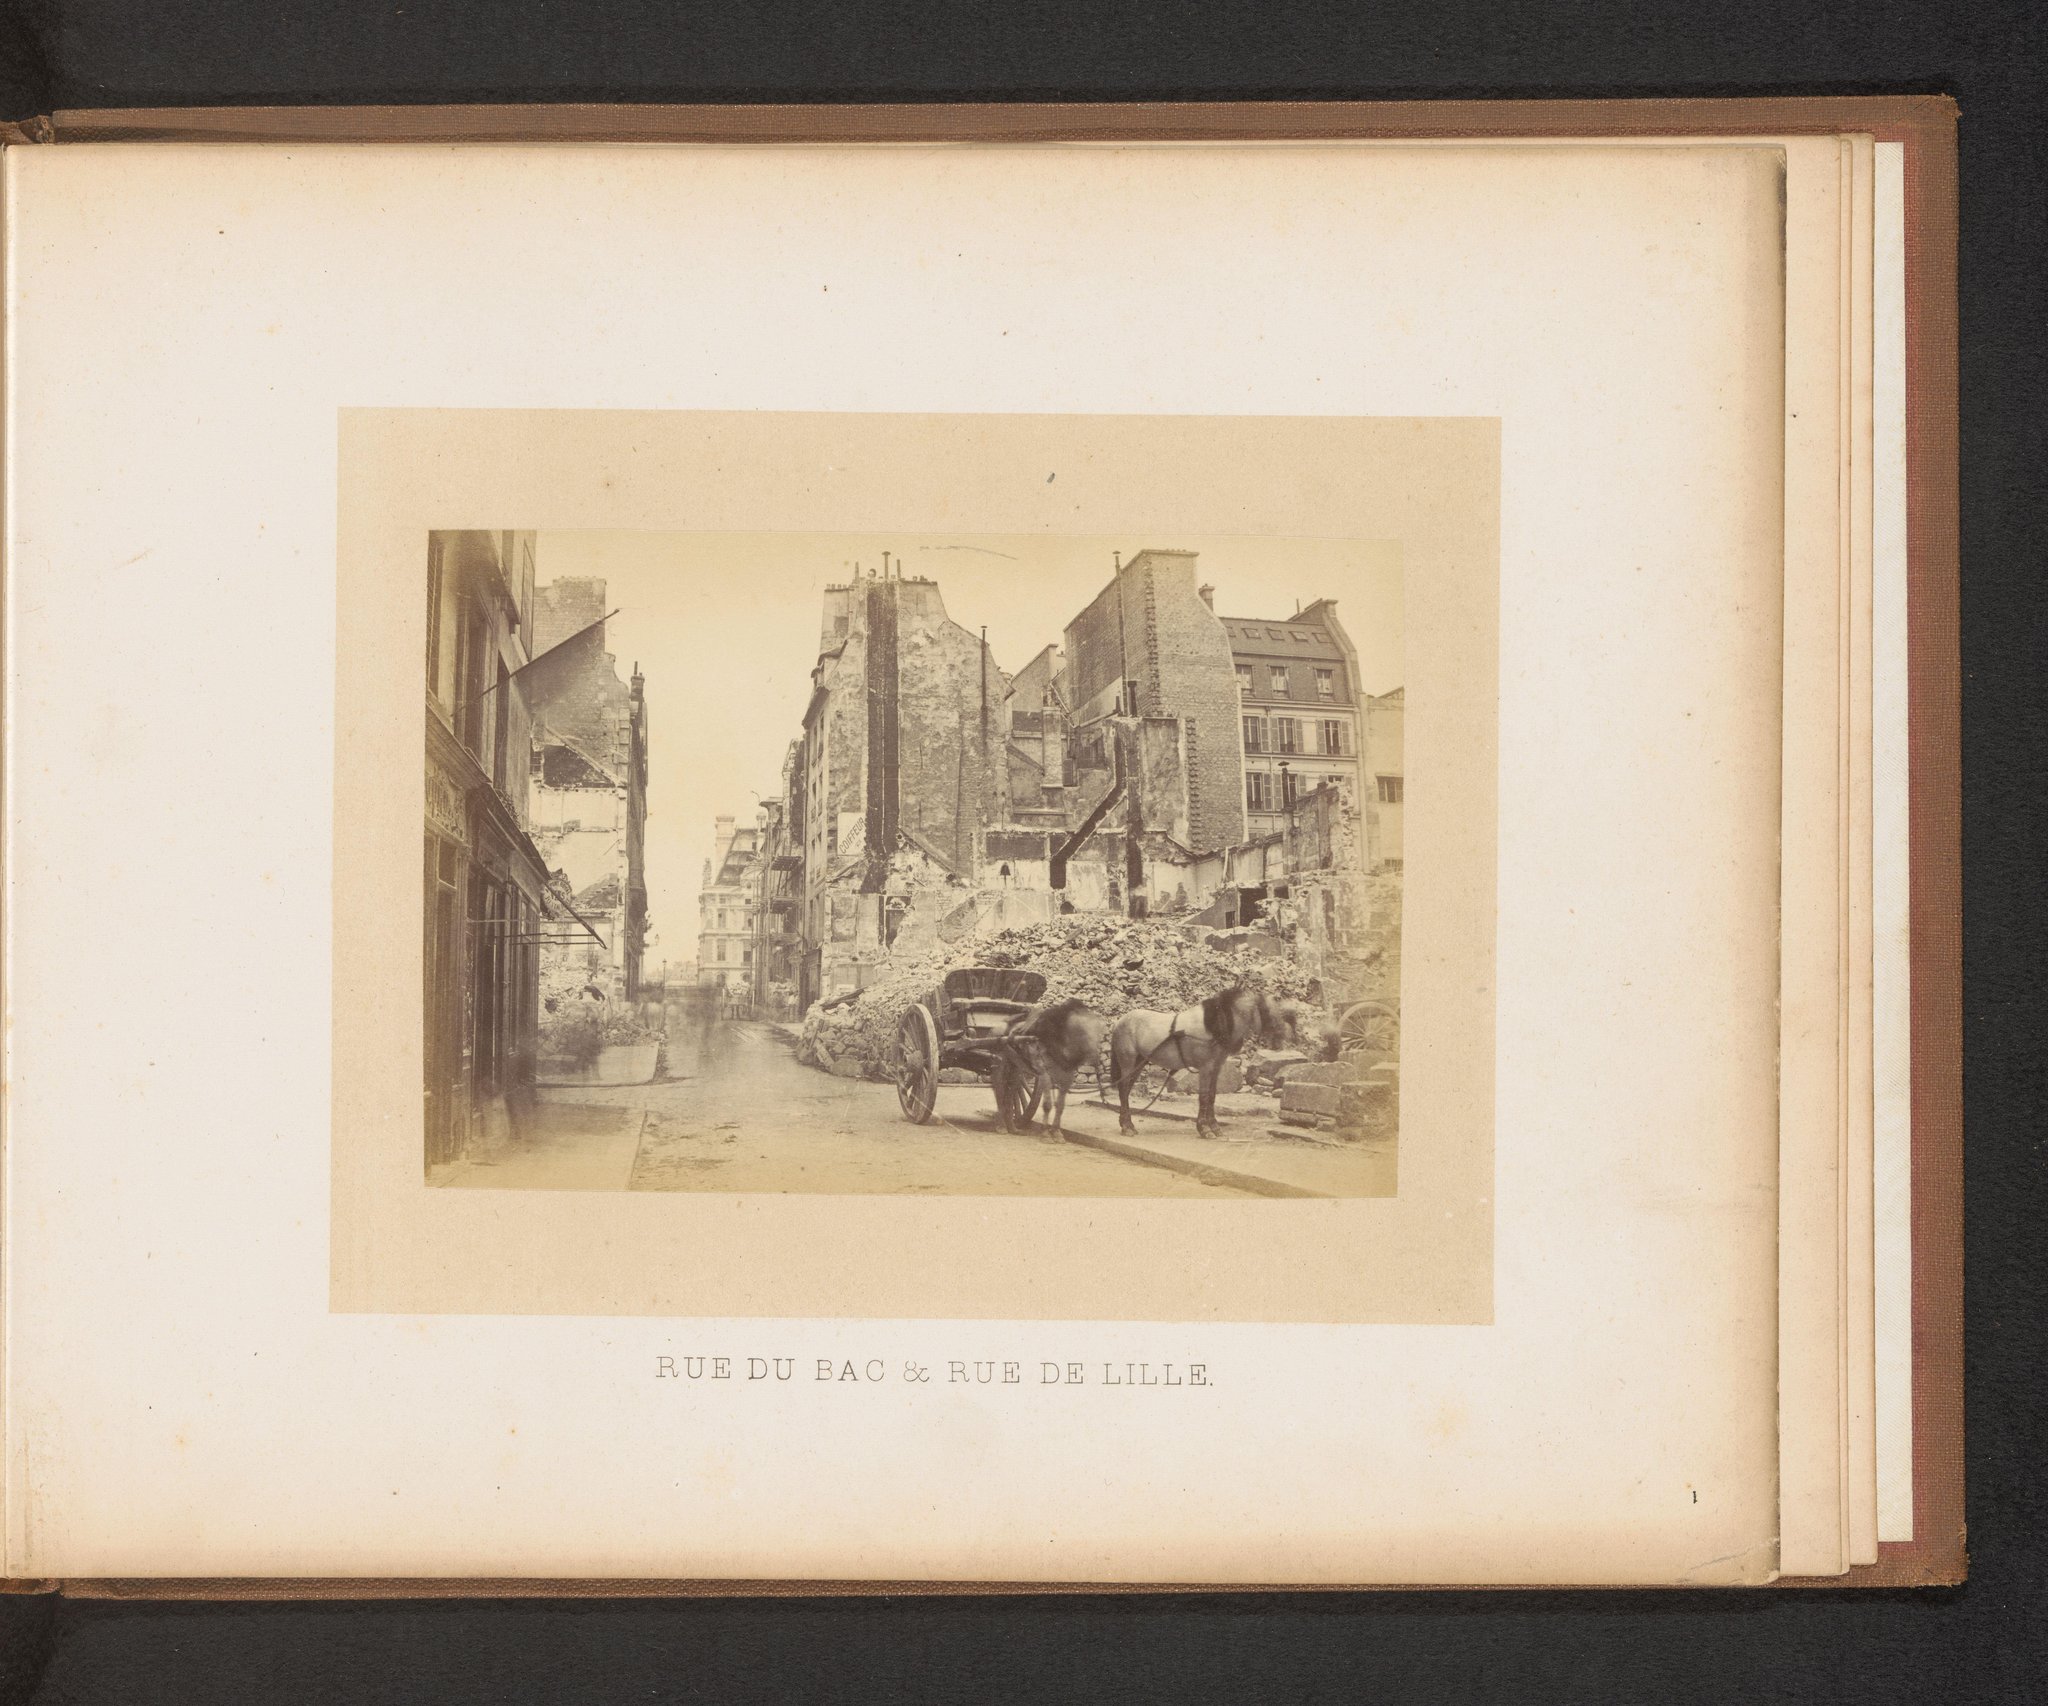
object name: photograph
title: Rue du Bac & Rue de Lille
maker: Anonymous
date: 1871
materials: photographic support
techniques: albumen print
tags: two-wheeled, animal-drawn vehicle, theatre (building), street, paris